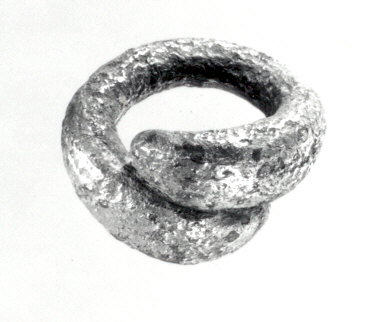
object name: spiral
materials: silver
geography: syria